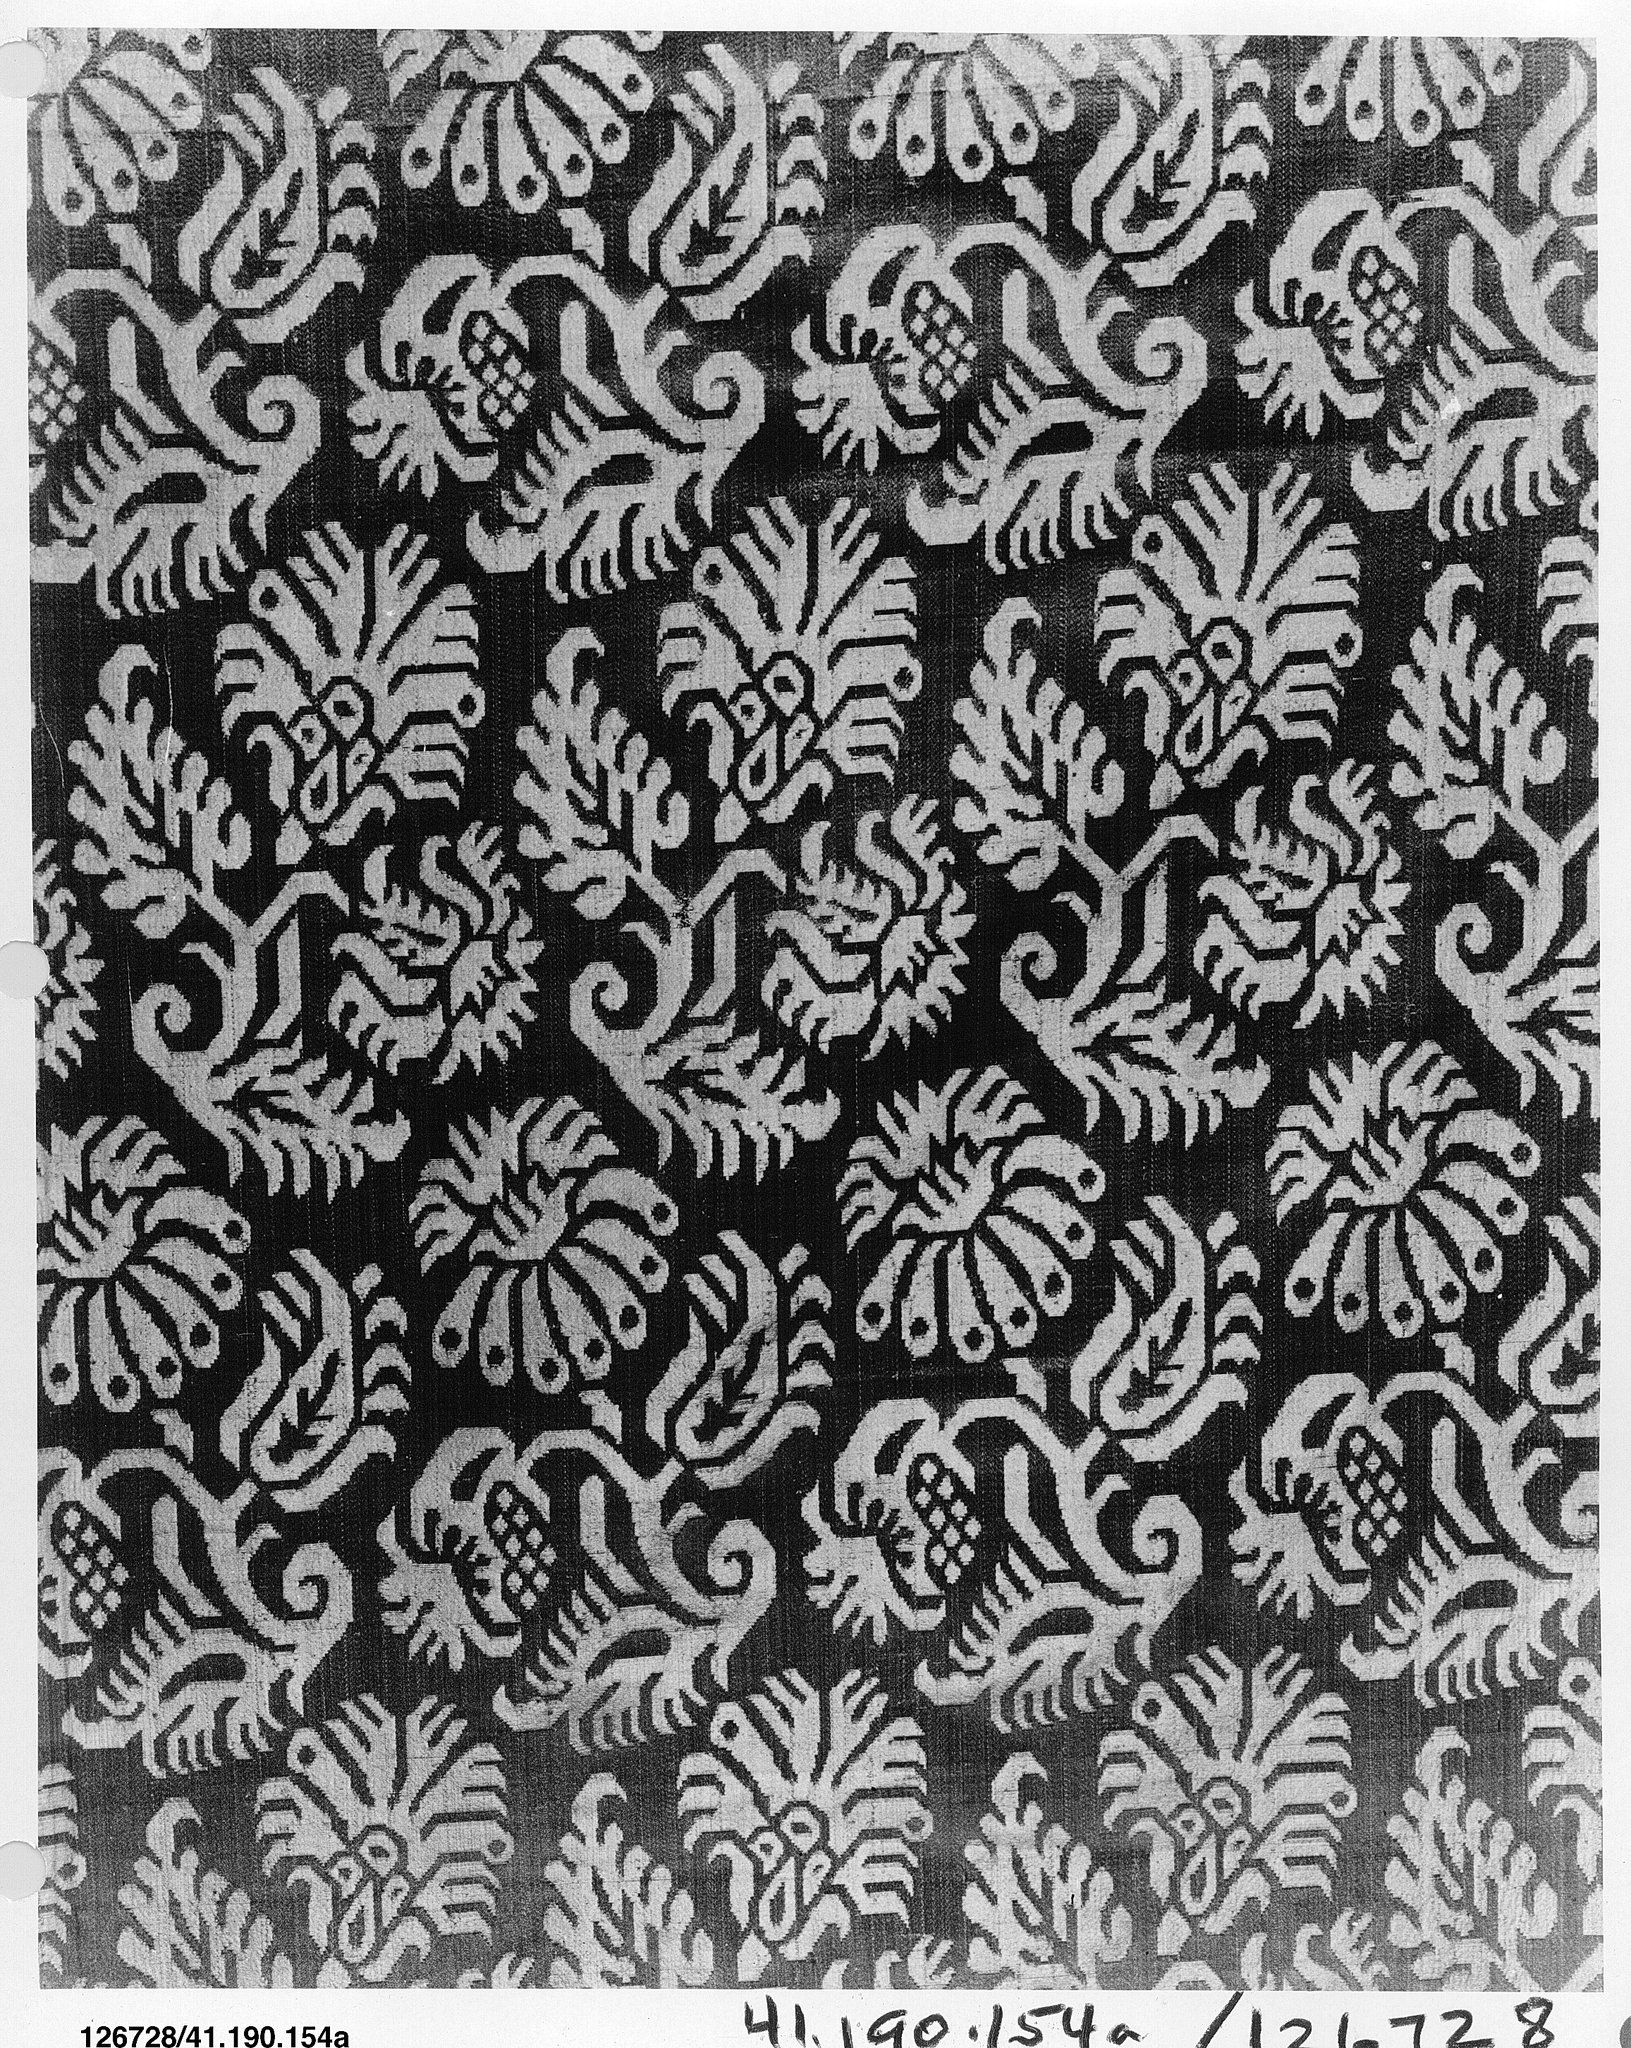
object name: piece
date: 1601-1700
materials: silk